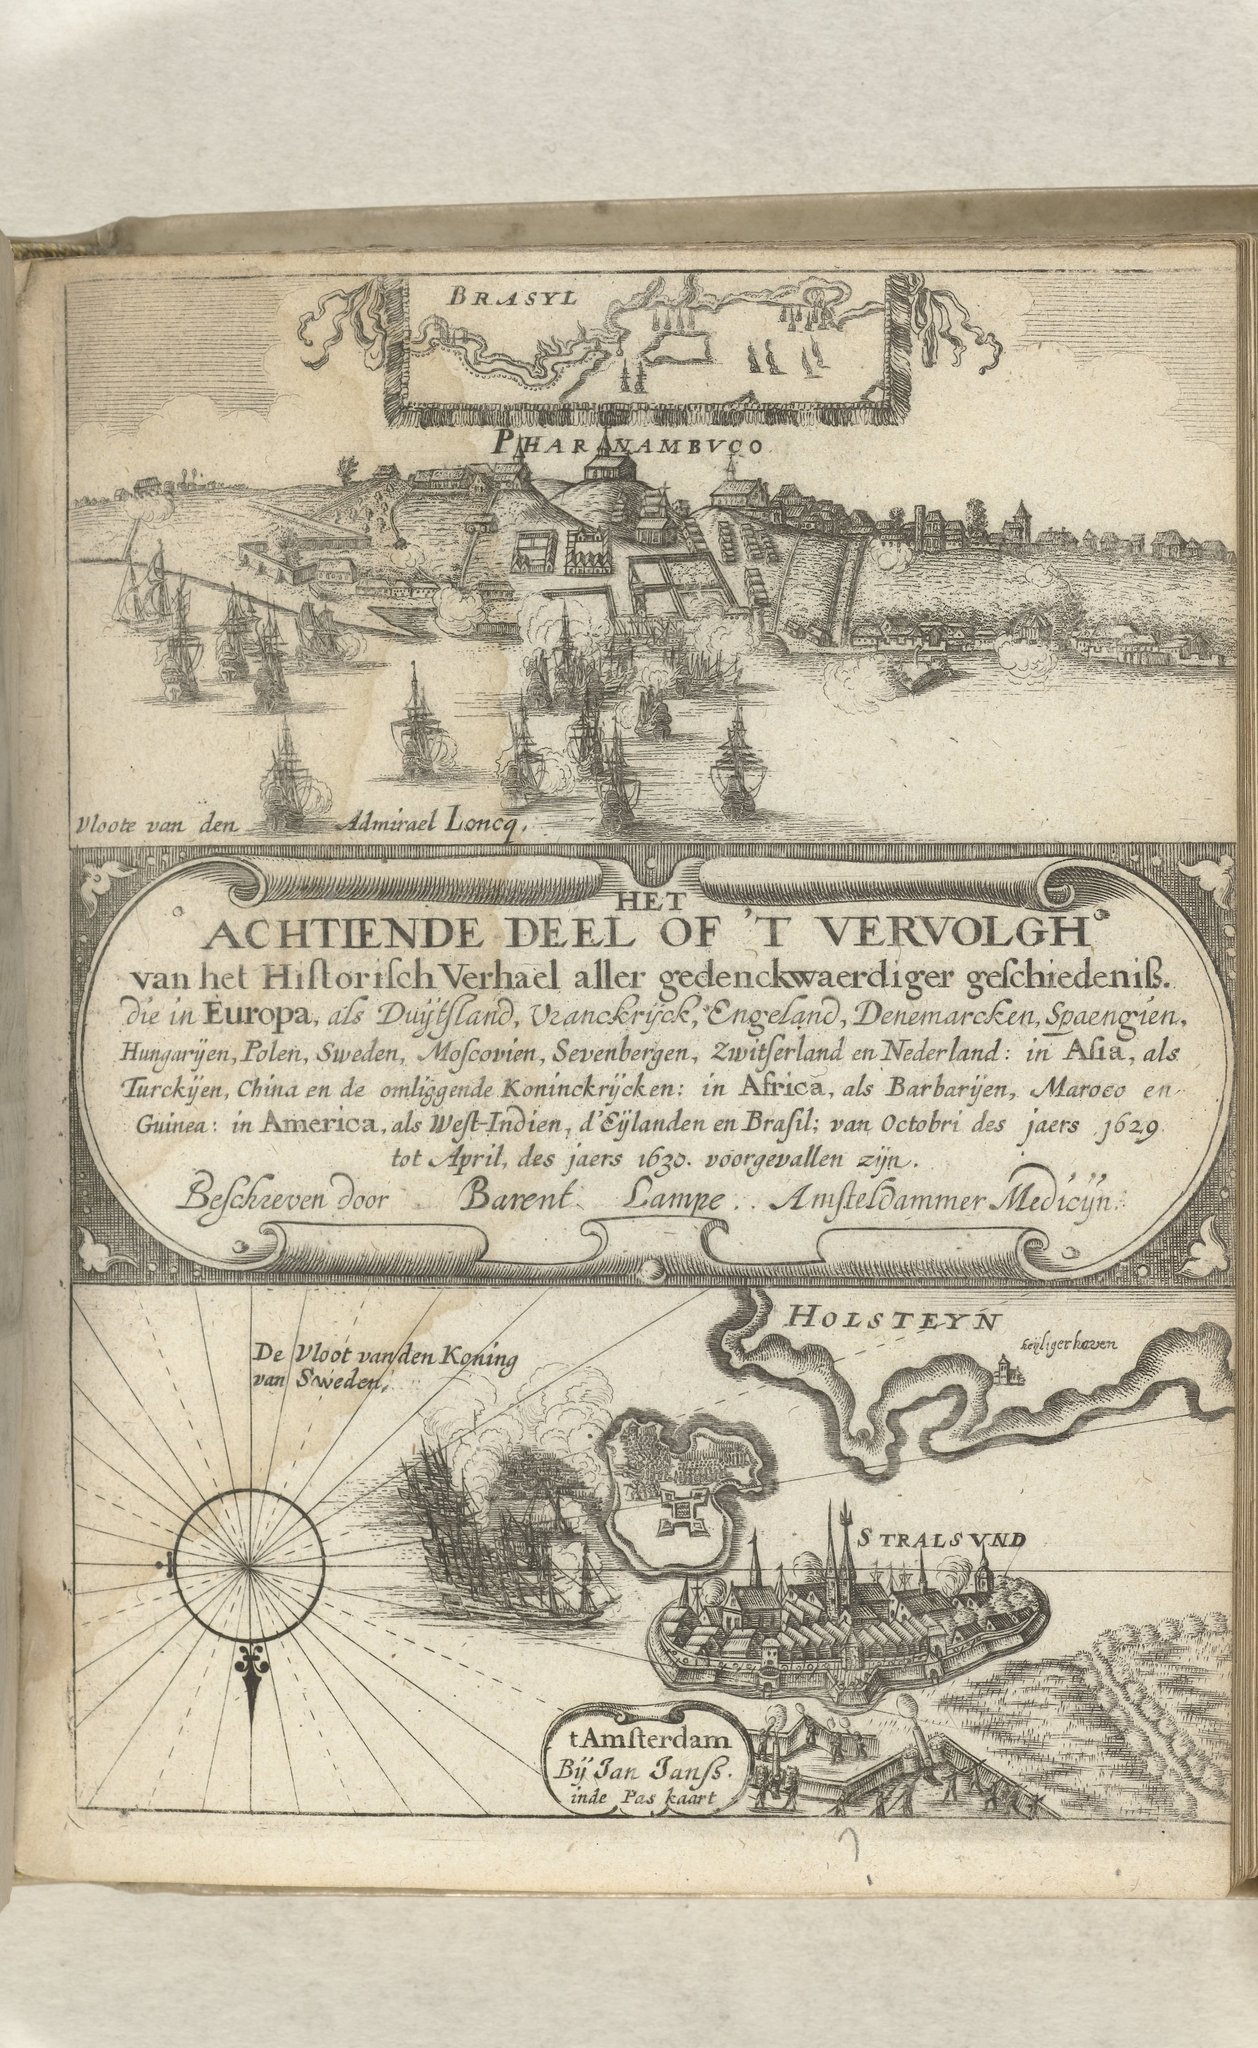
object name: print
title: Titelblad van Historisch verhael, band 6 (dl. 18), 1629-1630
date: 1629-1630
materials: paper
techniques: etching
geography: amsterdam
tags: battle (+ naval force)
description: Titelblad van Historisch Verhael, band 6 (dl. 18), 1629-1630. Titelblad met twee voorstellingen. Boven de verovering van Olinda te Pernambuco door de vloot onder admiraal Lonck, 13 februari 1630. Onder de Zweedse vloot voor Stralsund. In het midden een cartouche met de titel.